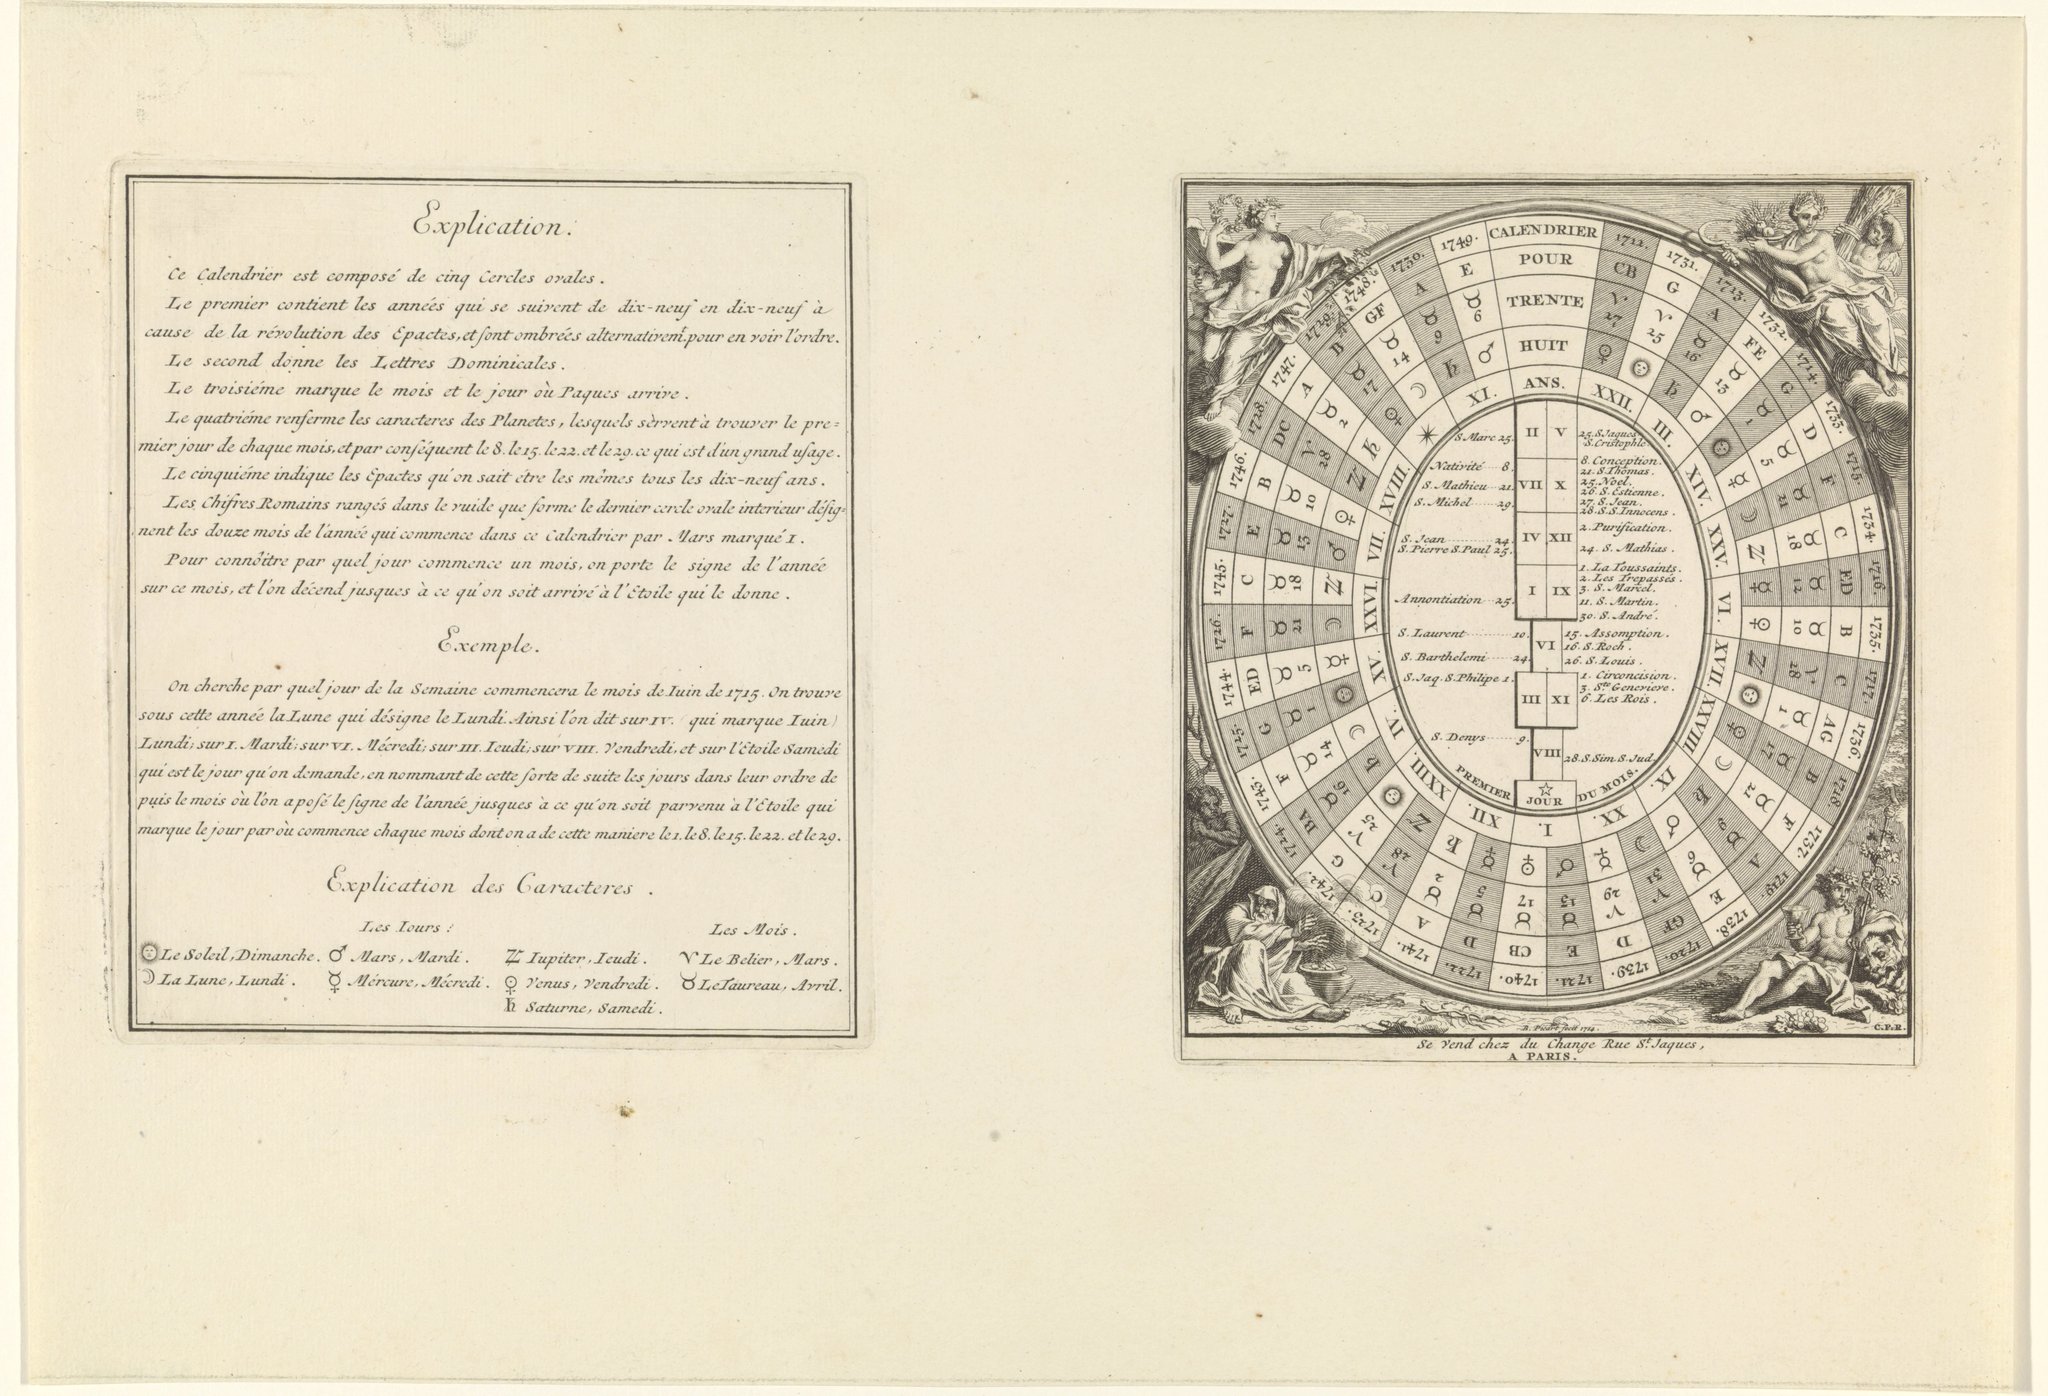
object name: book illustration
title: Kalender voor het jaar 1711 tot en met het jaar 1749 en toelichting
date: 1714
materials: paper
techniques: engraving, etching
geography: paris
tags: calendar, almanac, seasons of the year (esp. personifications); 'stagione', 'le quattro stagione dell'anno' (ripa)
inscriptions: collector's mark: Lugt 2228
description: Onversneden blad met een kalender en tekst. Links: Tekst in het Frans met een uitleg over de kalender. Rechts: Een ovale kalender, voor het jaar 1711 tot en met het jaar 1749. In het midden een opsomming van christelijke feestdagen en feestdagen van heiligen in het Frans. In de hoeken de personificaties van de vier jaargetijden.